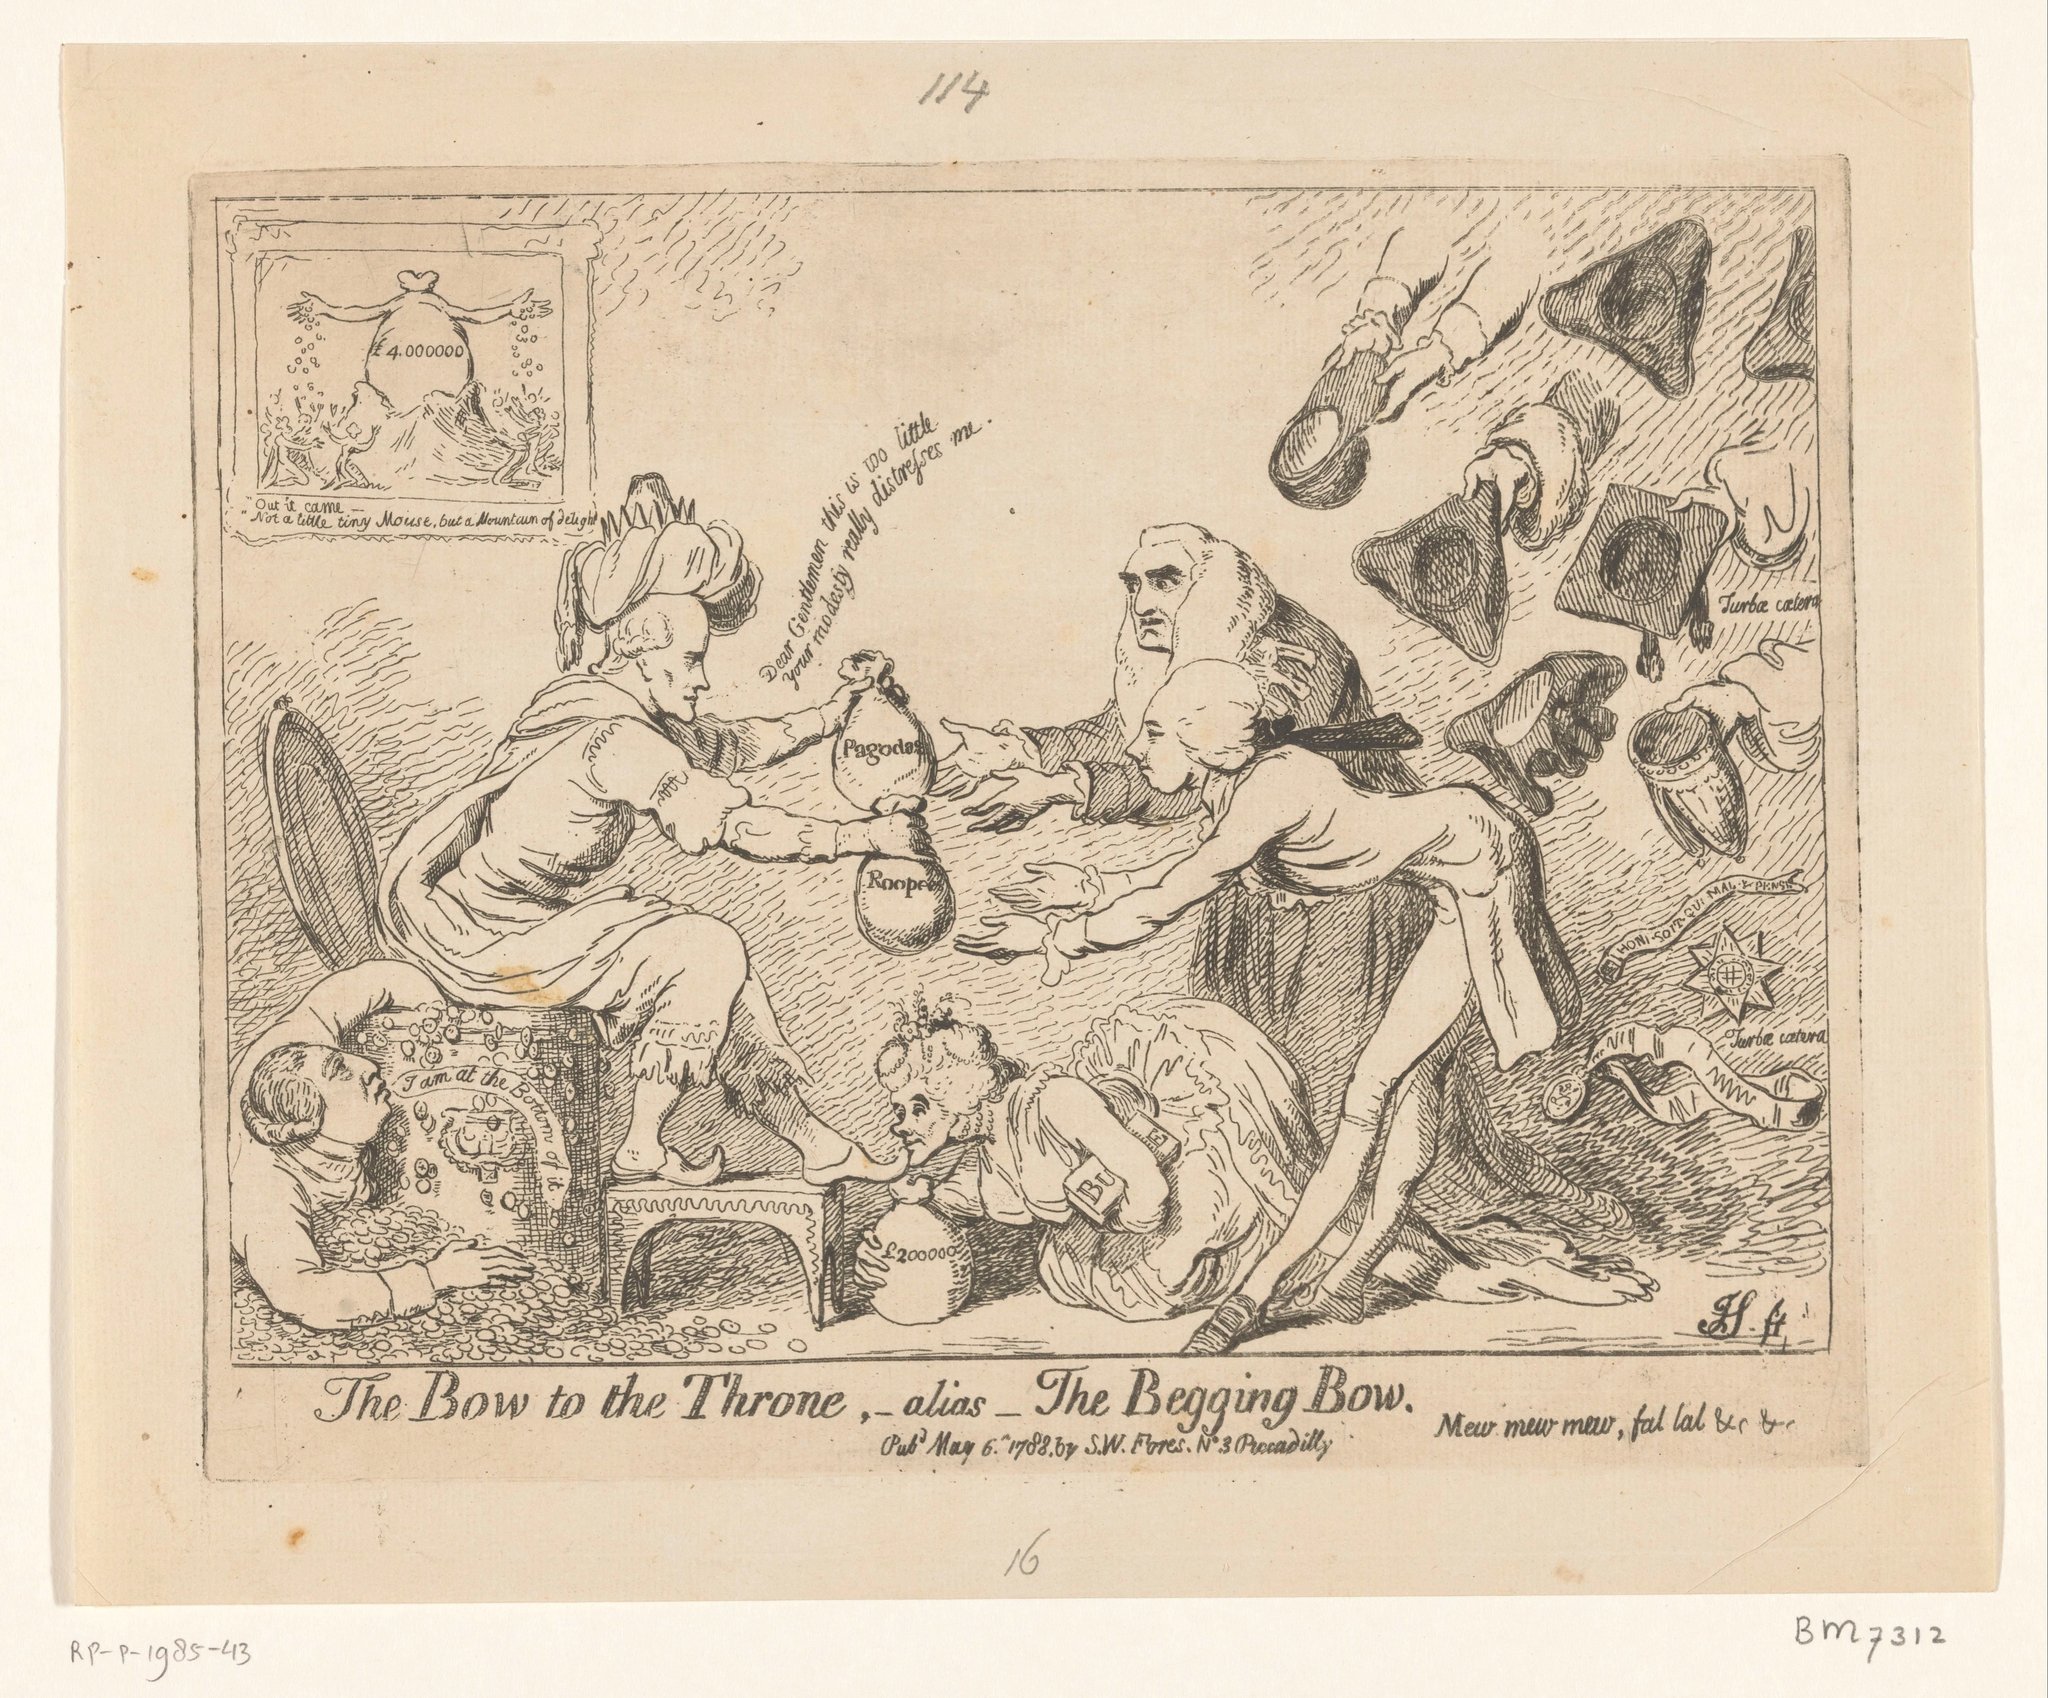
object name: cartoon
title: Spotprent op Warren Hastings, 1788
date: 1788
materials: paper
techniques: etching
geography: england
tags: london, politician, gifts being accepted, bribery, political caricatures and satires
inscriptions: collector's mark: Lugt 2228, collector's mark: Lugt 2760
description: Spotprent op Warren Hastings, 1788, Engels koloniaal bestuurder. In 1785 beschuldigd van corruptie en onderwerp van een lang proces. Hastings als een sultan op zijn troon deelt hier zakken met geld uit, o.a.aan Thurlow en Pitt.